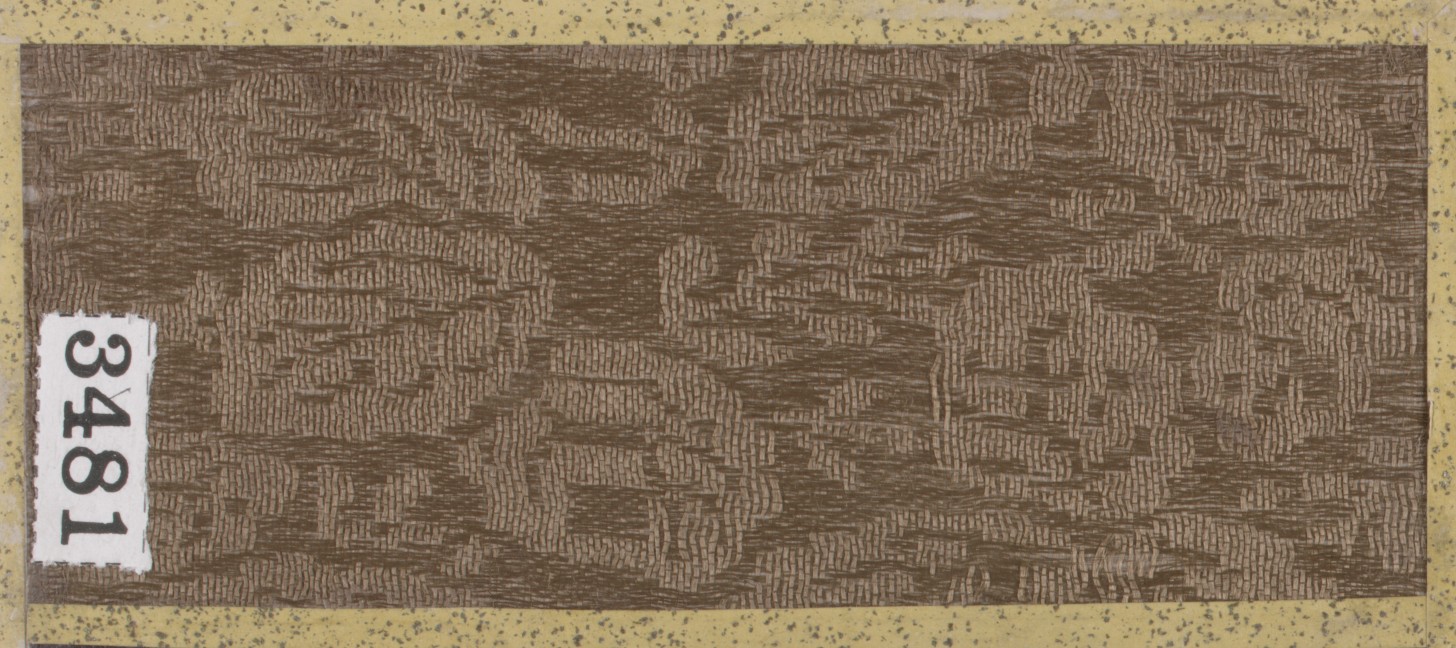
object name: sample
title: Textile Sample from Sample Book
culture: japanese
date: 1801-1900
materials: silk